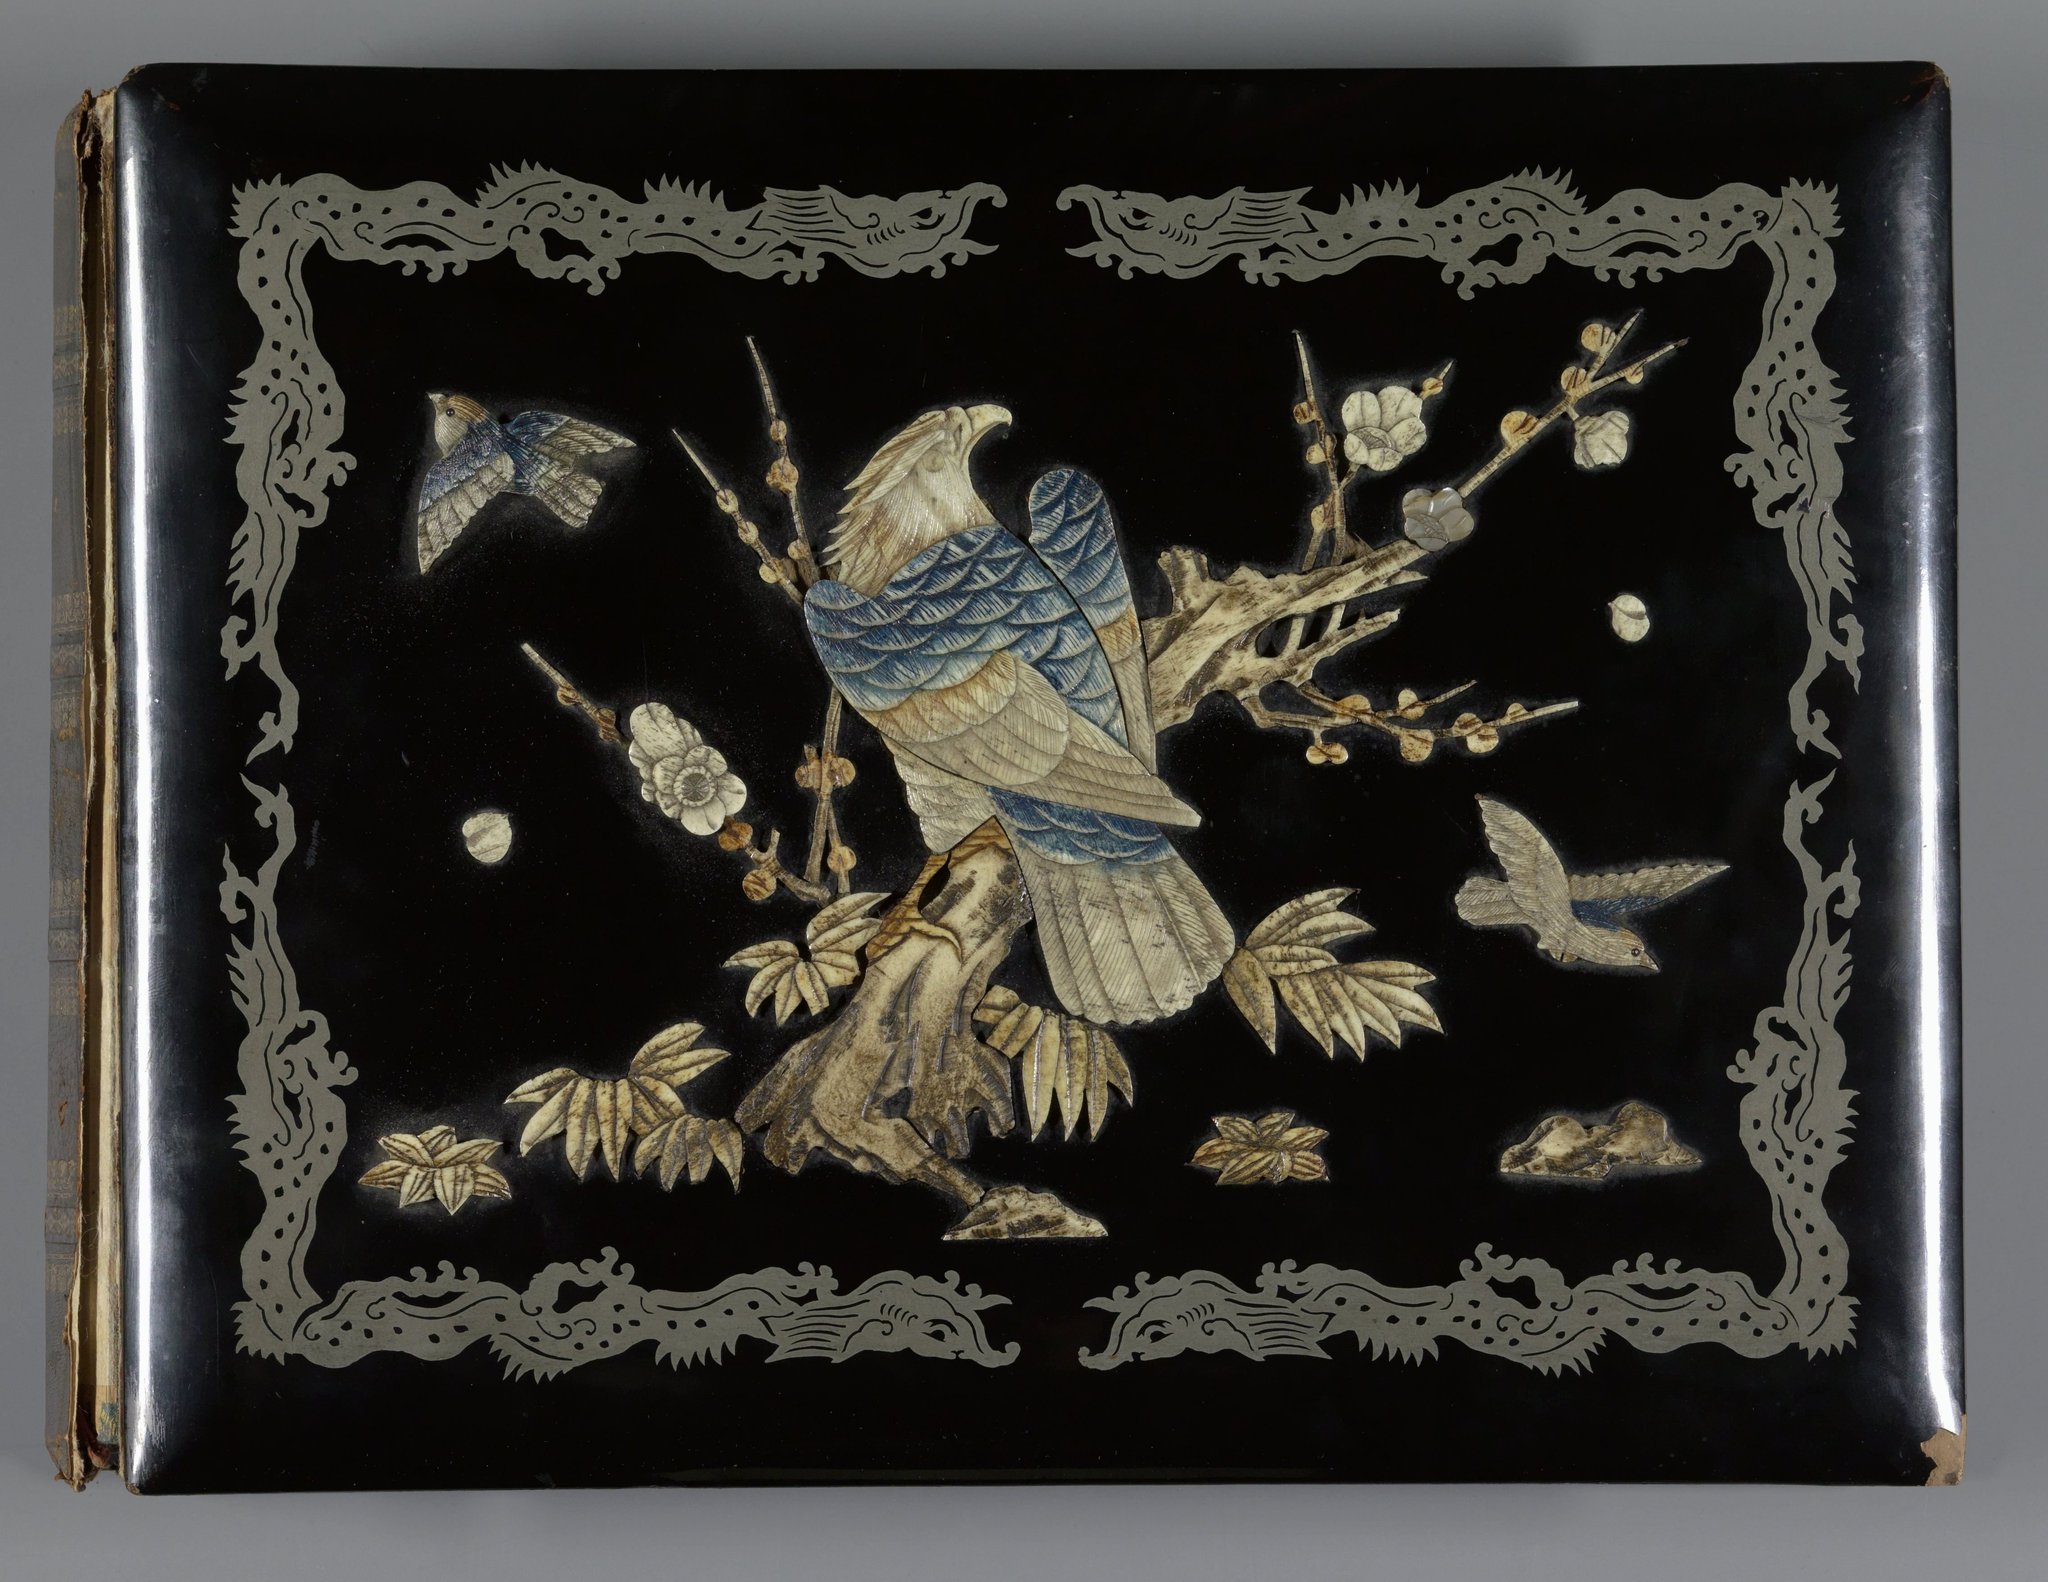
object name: photograph album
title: Fotoalbum (leeg)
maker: Anonymous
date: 1860-1900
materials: cardboard, paint, ivory, lacquer, leather, mother of pearl, paper, silk, textile, watercolor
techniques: bookbinding, brush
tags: predatory birds: eagle, book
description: Fotoalbum in leren band met twee lakpanelen. Het voorpaneel heeft een versiering uitgevoerd in ivoor en parelmoer: een adelaar zittend op een bloeiende tak en twee vogels. Het achterpaneel is effen zwart. Het album bevat negen kartonnen bladen overtrokken met zijde. Elke pagina heeft uitsparingen voor twee kabinetfoto's. Daaromheen zijn geschilderde versieringen aangebracht: bloemen, vogels, bloeiende bomen, zeilboten en landschappen.